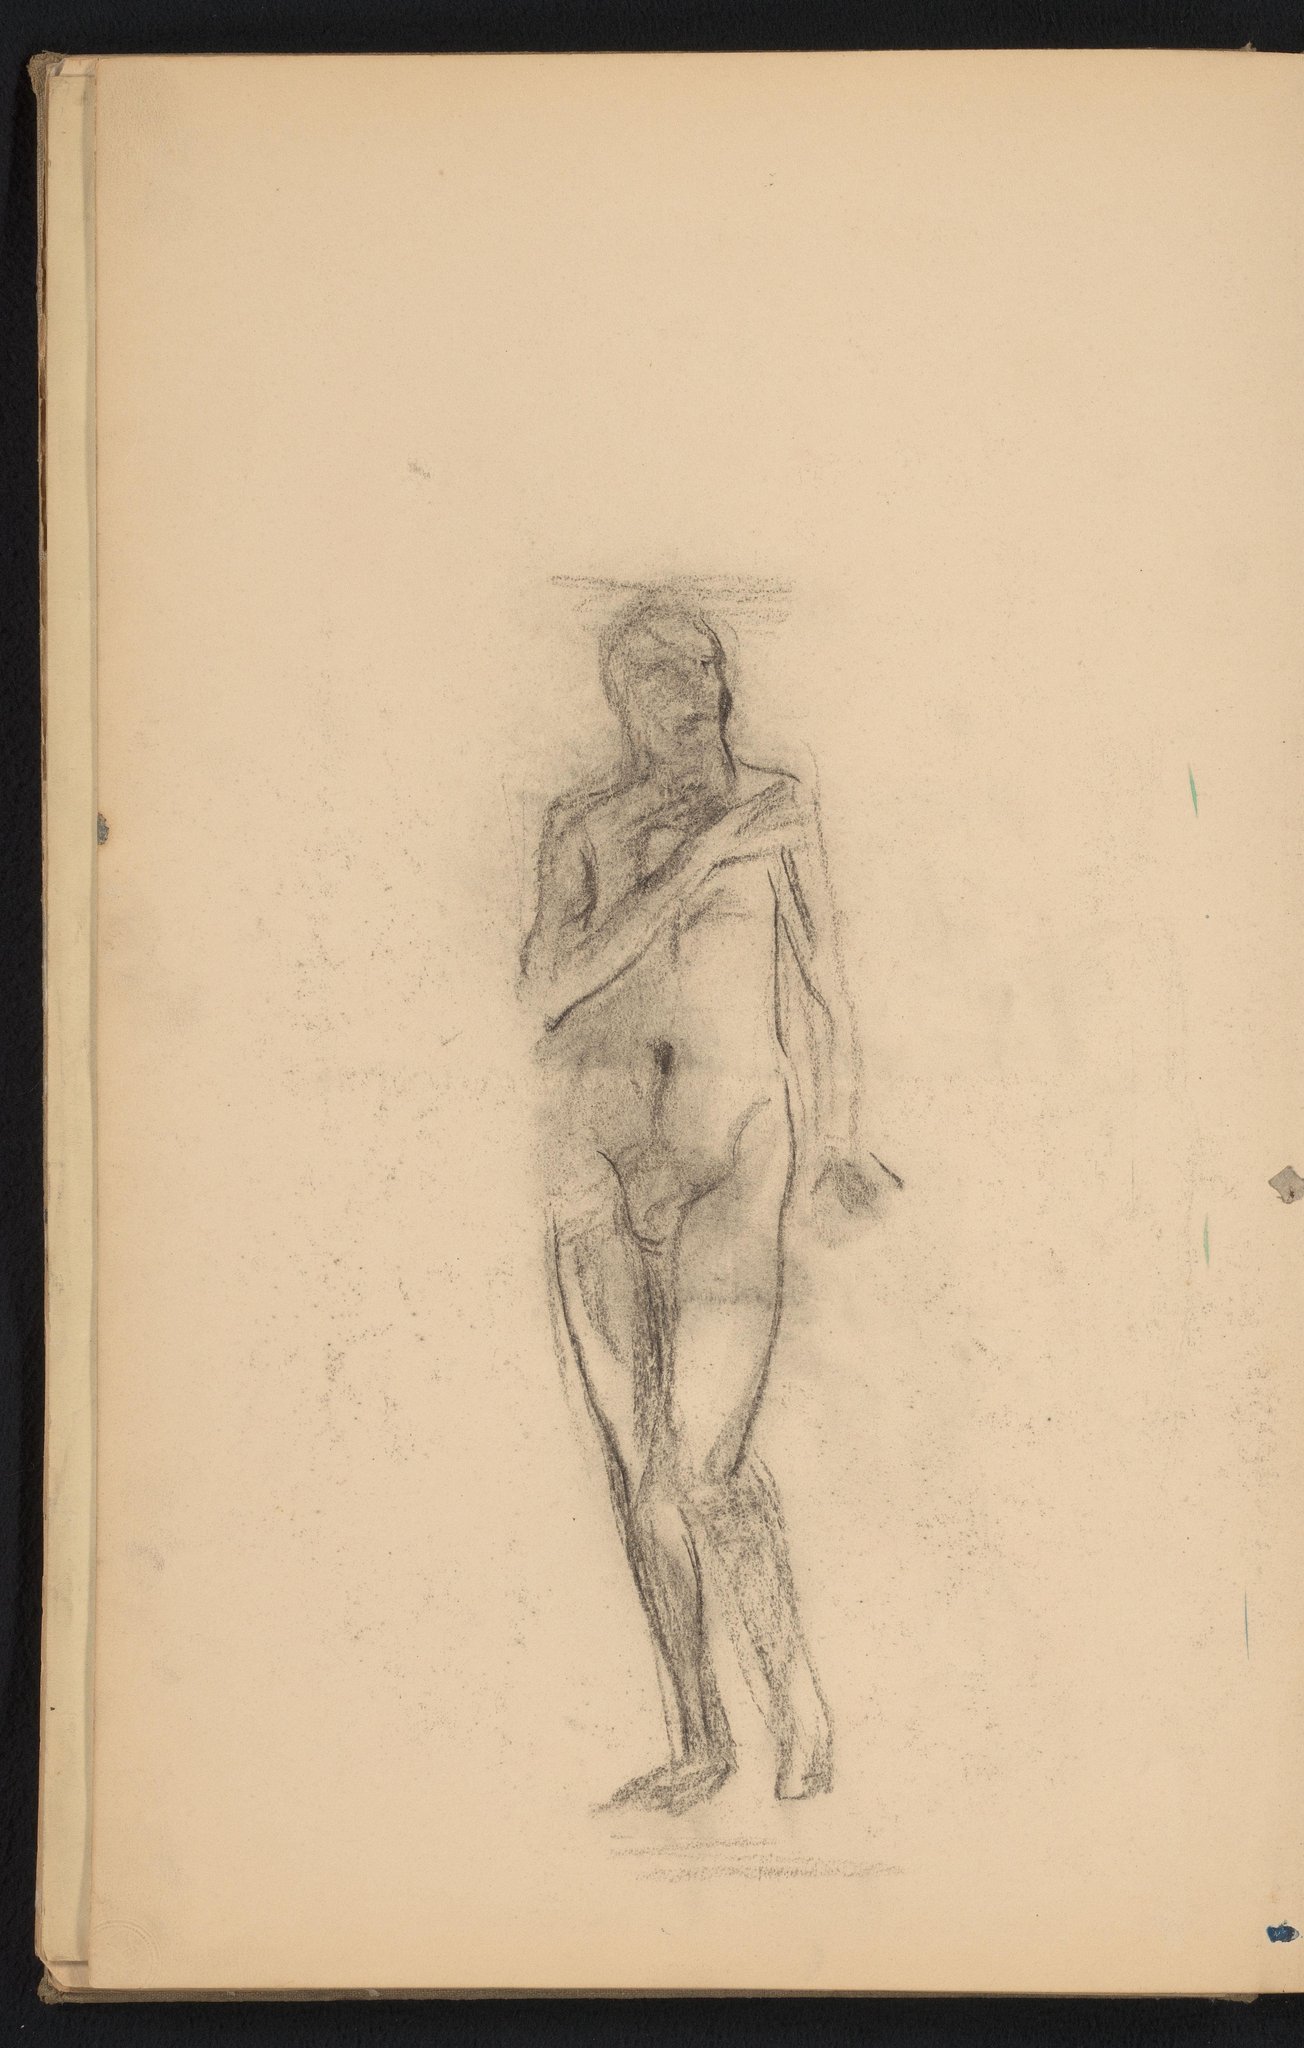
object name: sketchbook leaf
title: Staande naakte man met zijn arm over de borst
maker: huib luns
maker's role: draughtsman, print maker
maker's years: 1881-1942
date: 1908-1909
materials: charcoal, paper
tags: arm or hand held in front of the chest, the (nude) human figure; 'corpo humano' (ripa)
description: Blad 17 verso uit een schetsboek met 24 bladen.